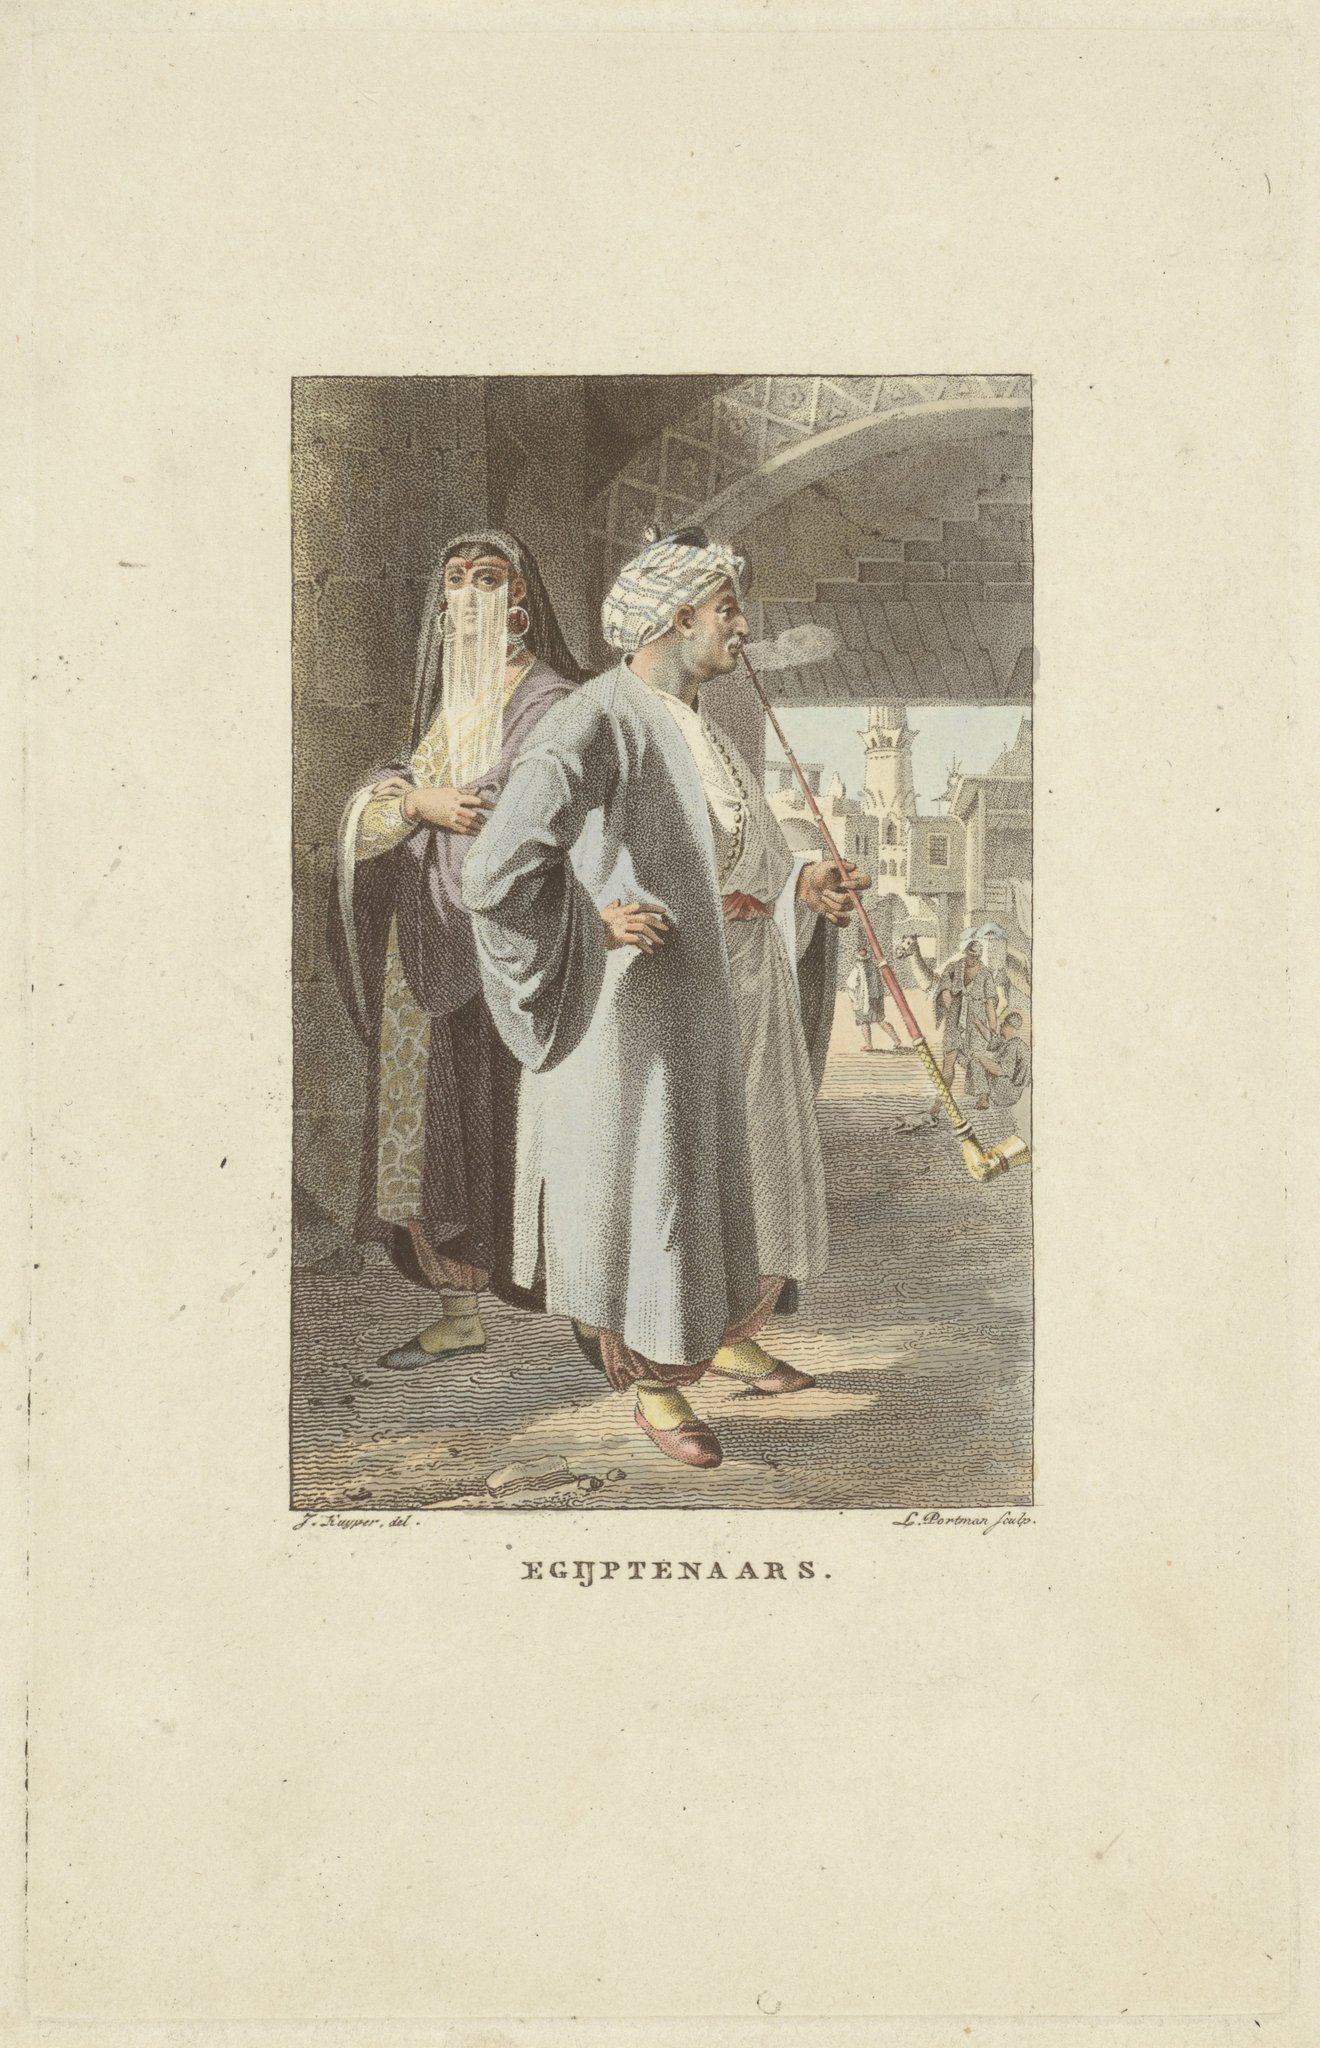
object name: book illustration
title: Egijptenaars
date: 1807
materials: paper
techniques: etching, hand coloring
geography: amsterdam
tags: pipe ~ tobacco, human races; peoples; nationalities (+ costume), veil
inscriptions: collector's mark: Lugt 2228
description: Illustratie uit: Stuart, Martinus. De mensch, zoo als hij voorkomt op den bekenden aardbol, deel VI, p. 254. Amsterdam: Johannes Allart, 1807.